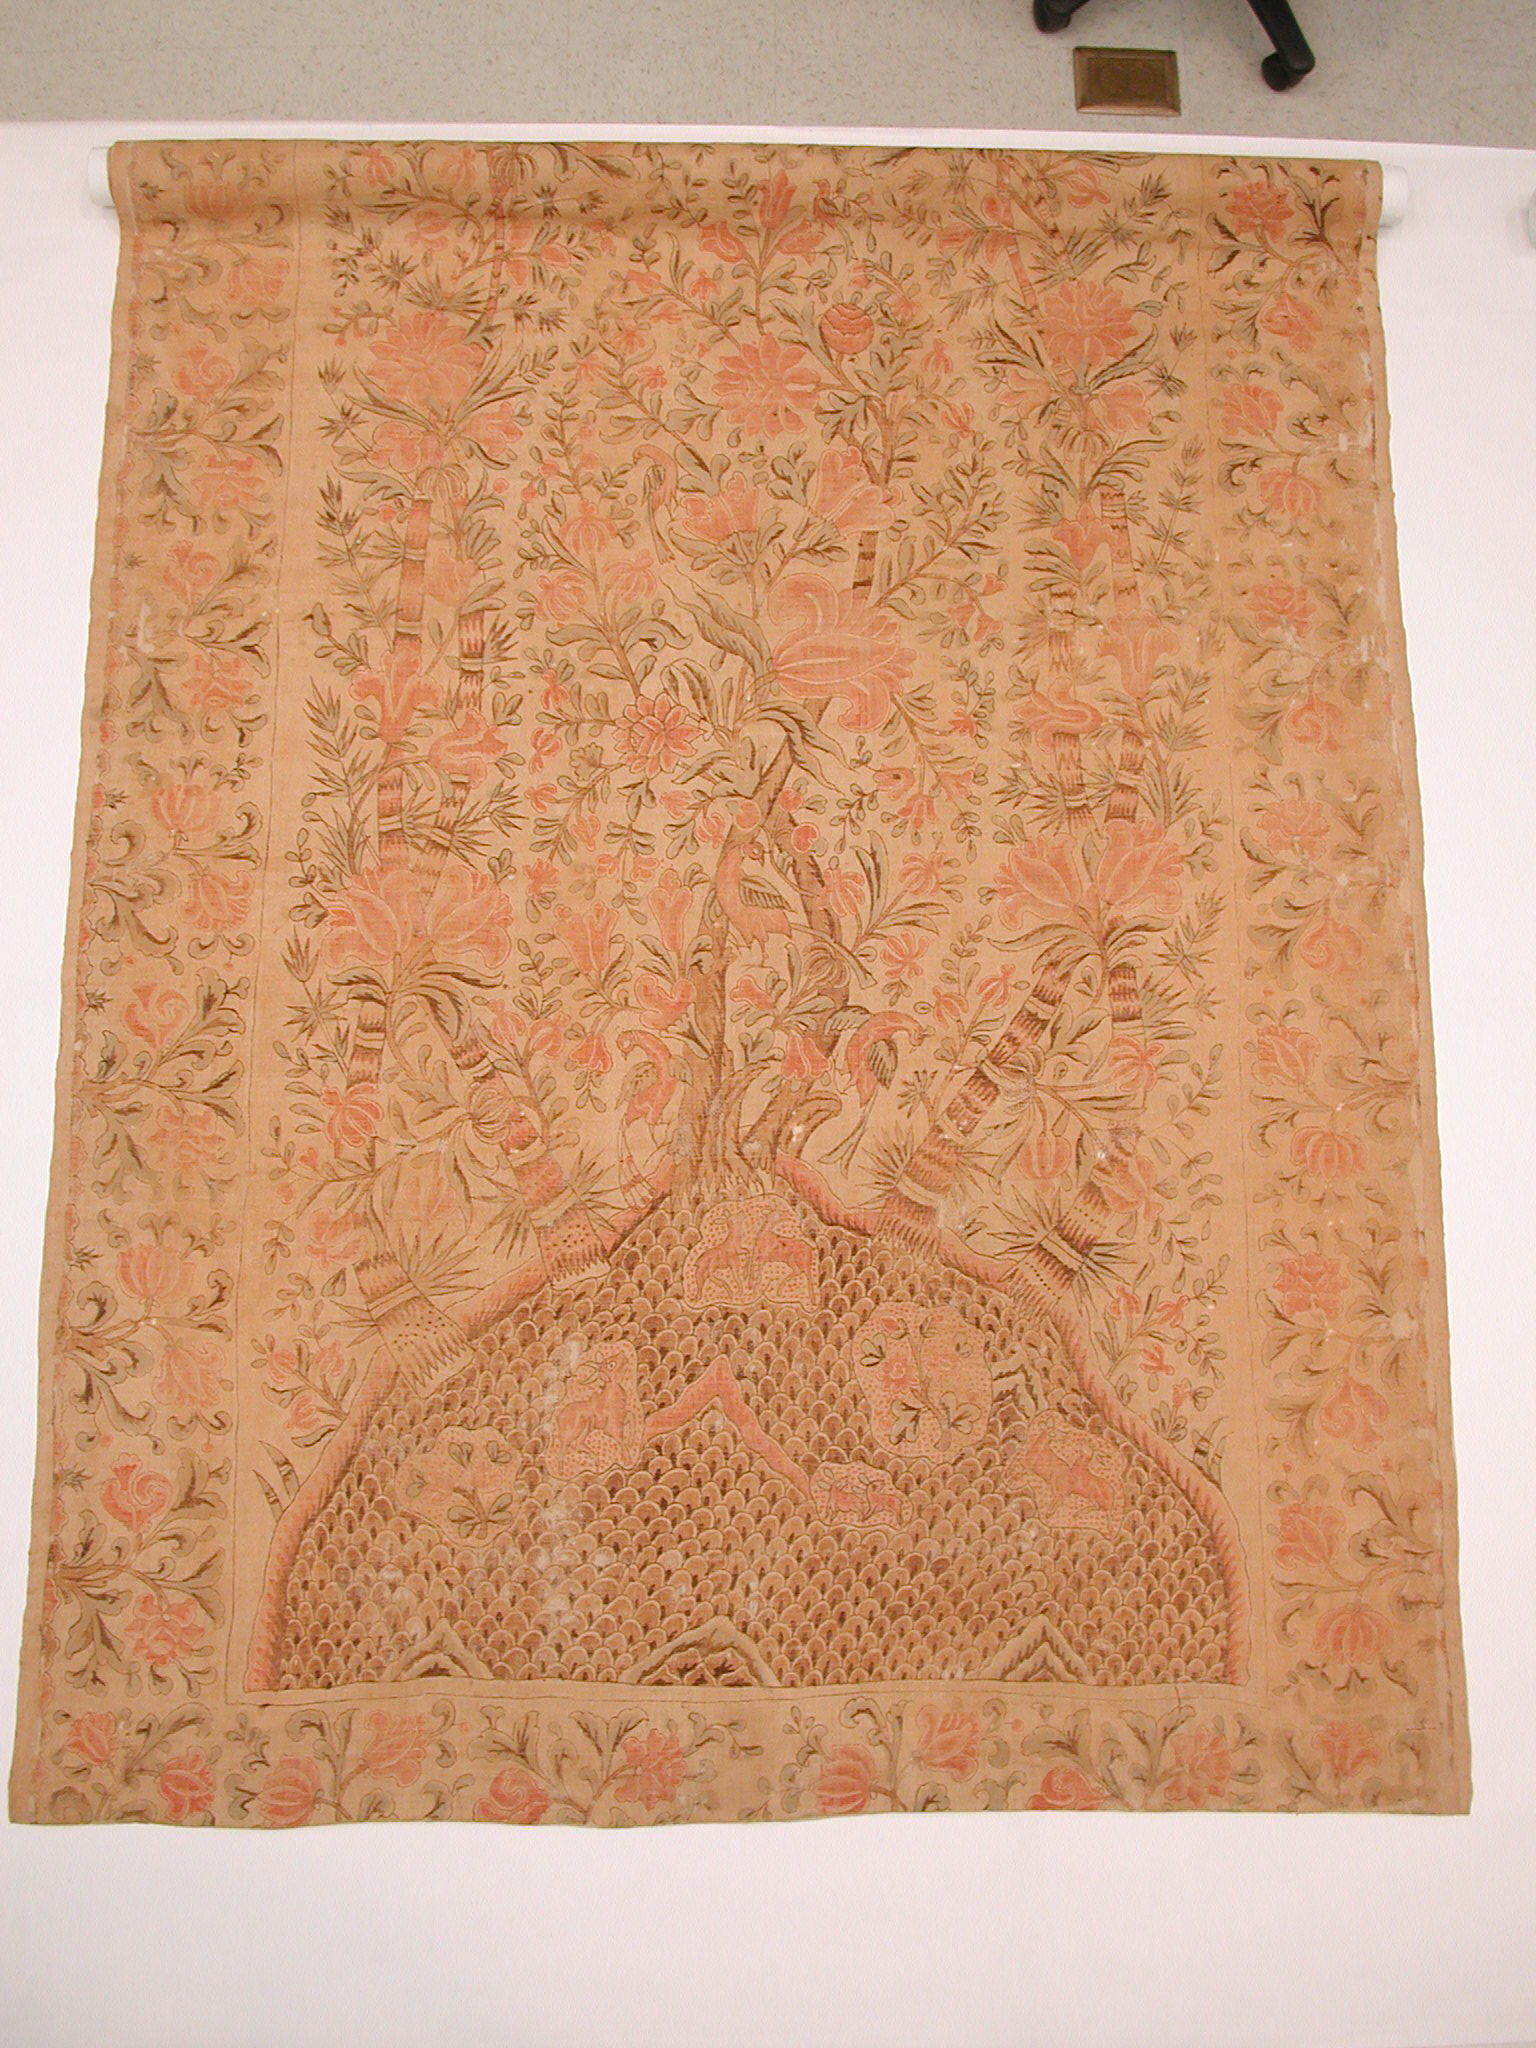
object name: hanging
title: Hanging (Palempore)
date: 1701-1733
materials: cotton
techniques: painting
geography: india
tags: animals,flowers